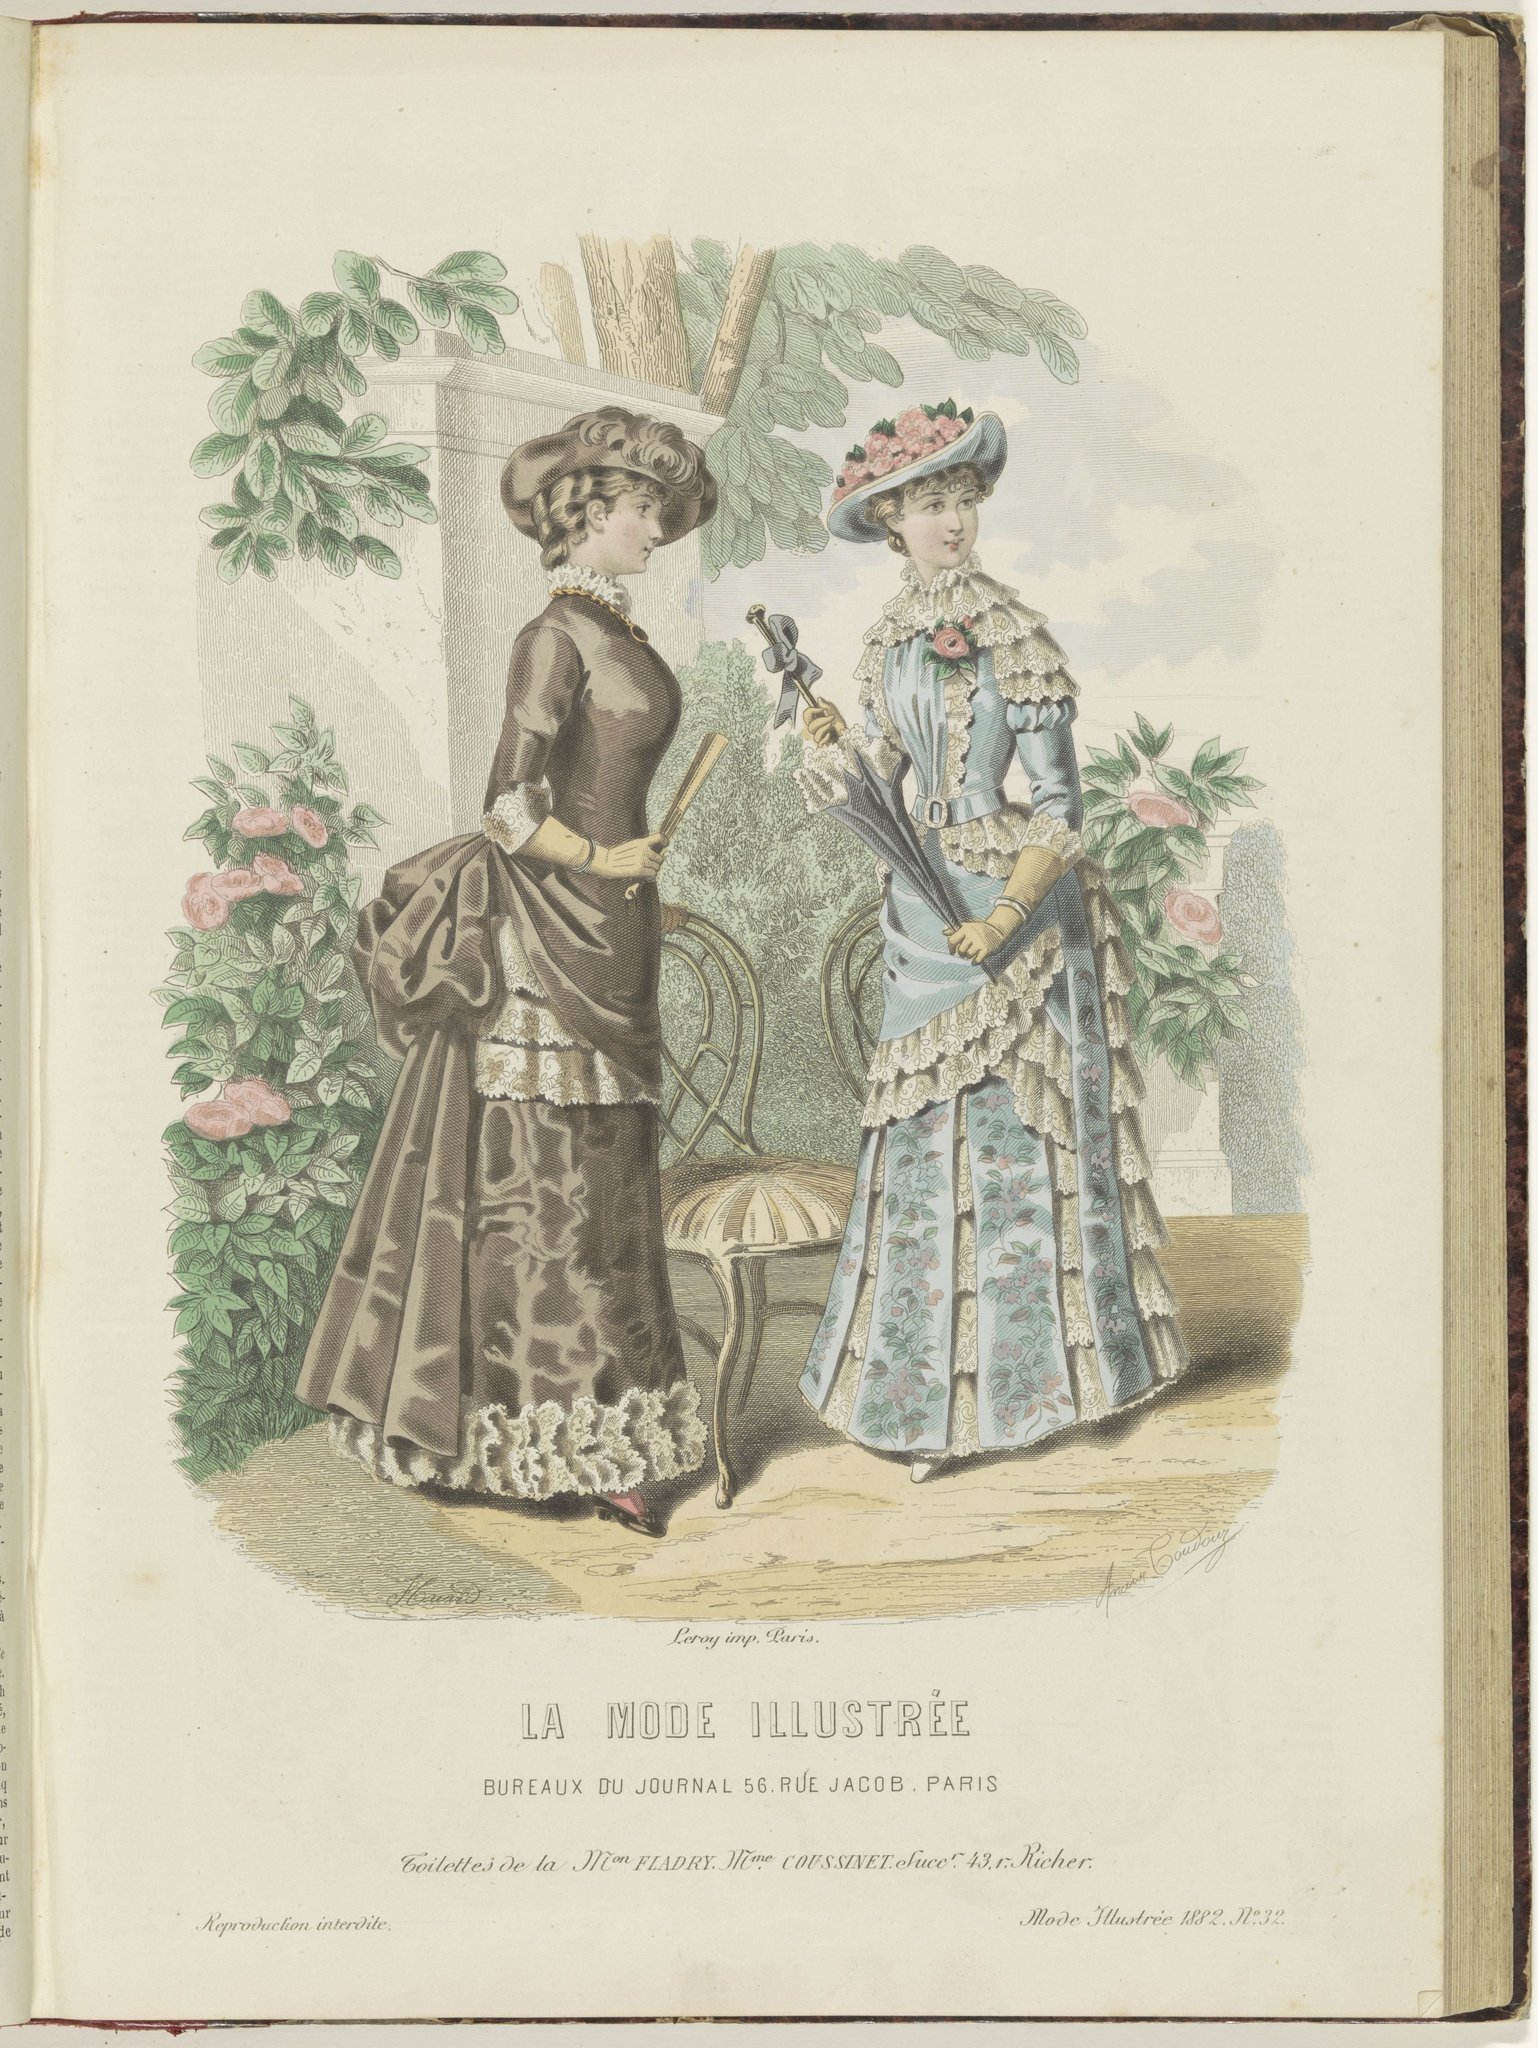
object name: magazine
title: La Mode Illustrée, Journal de la Famille, 1882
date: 1882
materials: paper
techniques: engraving, hand coloring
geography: paris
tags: fashion plates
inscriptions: date